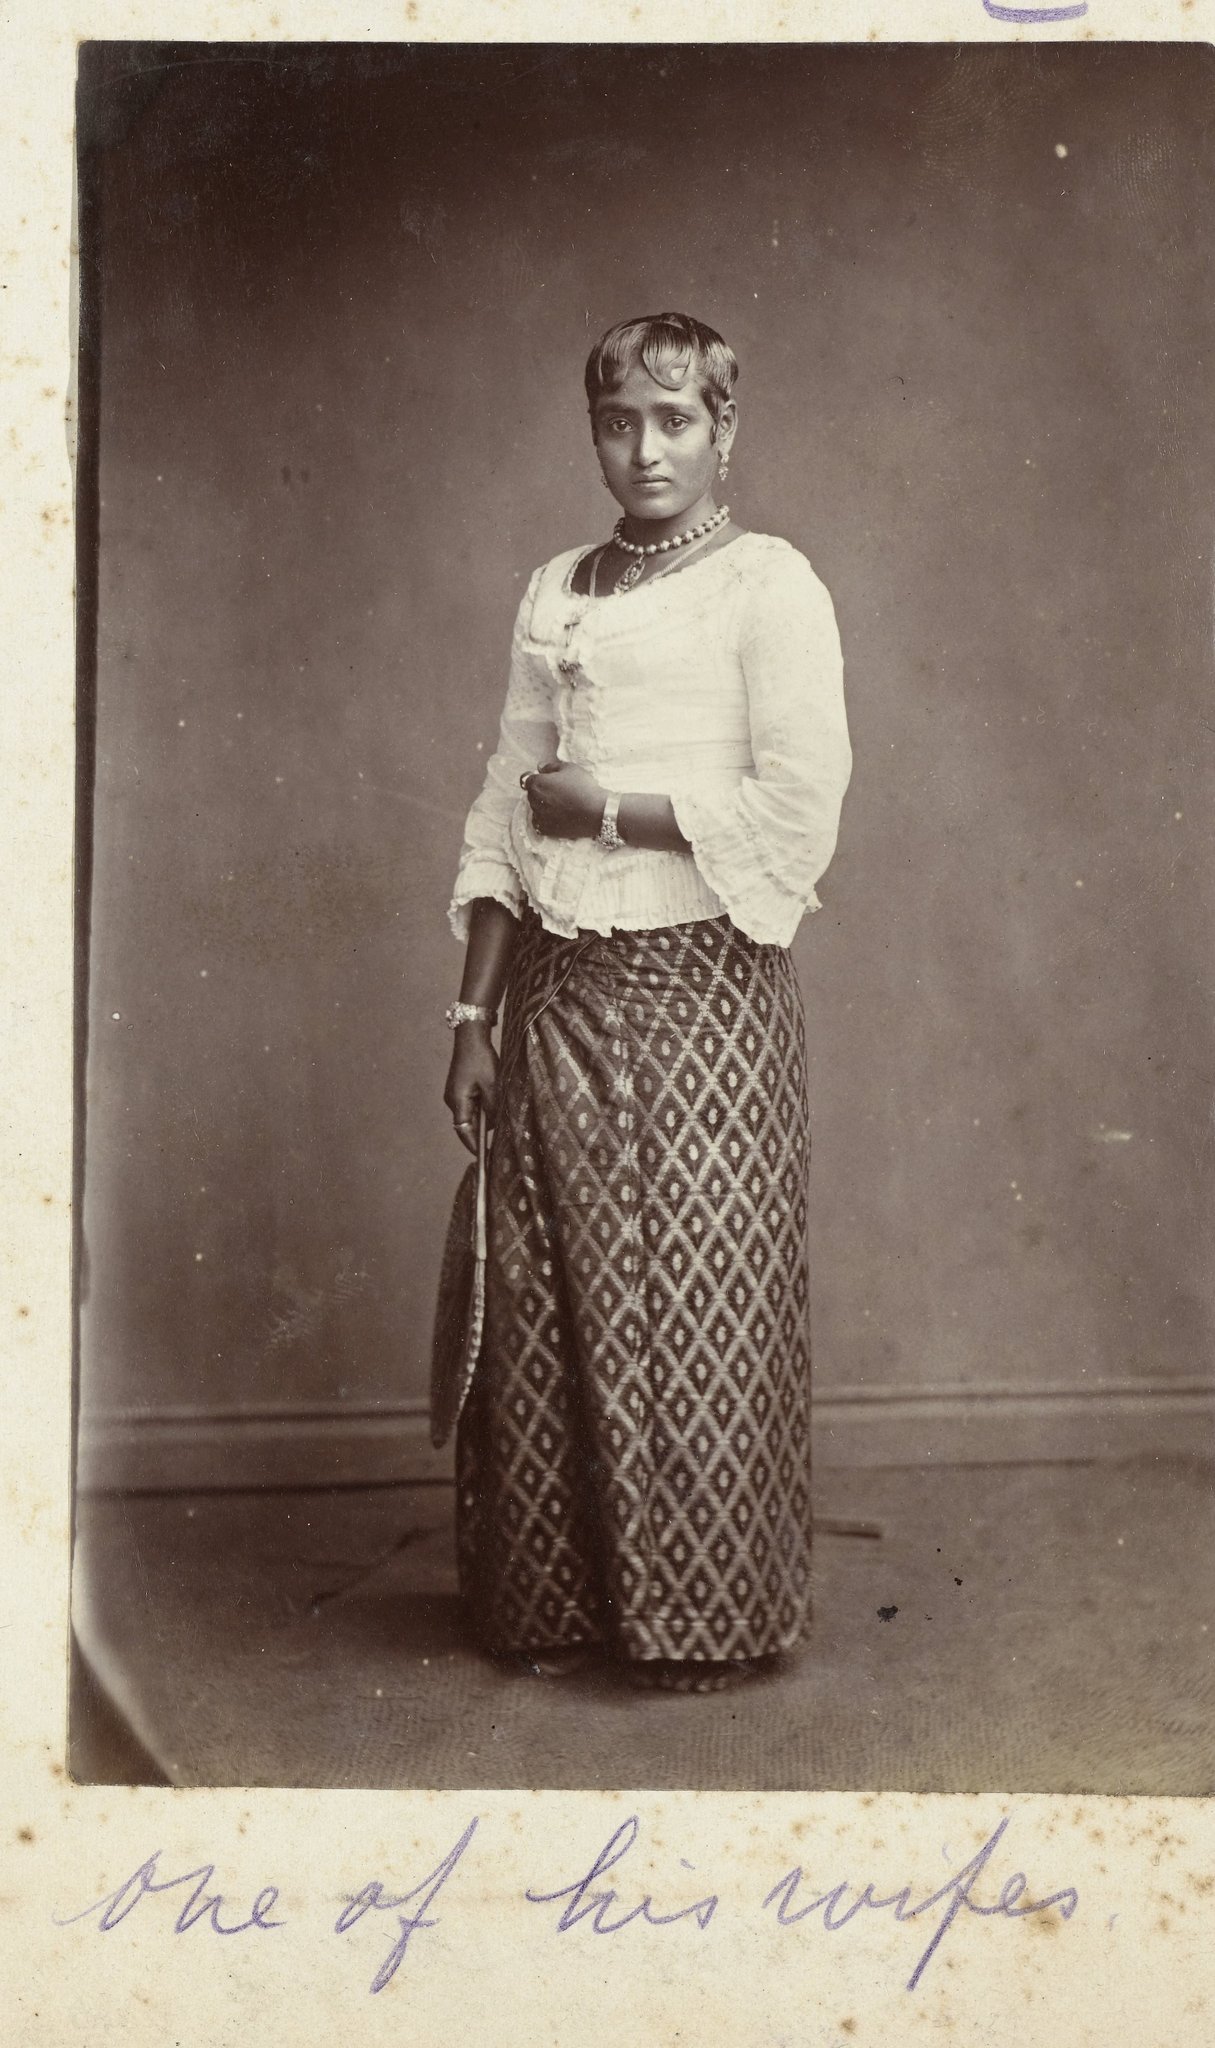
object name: photograph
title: One of his wifes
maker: Anonymous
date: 1890-1910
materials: cardboard, paper, photographic support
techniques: gelatin silver print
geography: netherlands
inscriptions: caption: ‘One of his wifes’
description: De vrouw is mogelijk een van de vrouwen van de koning van Rauden